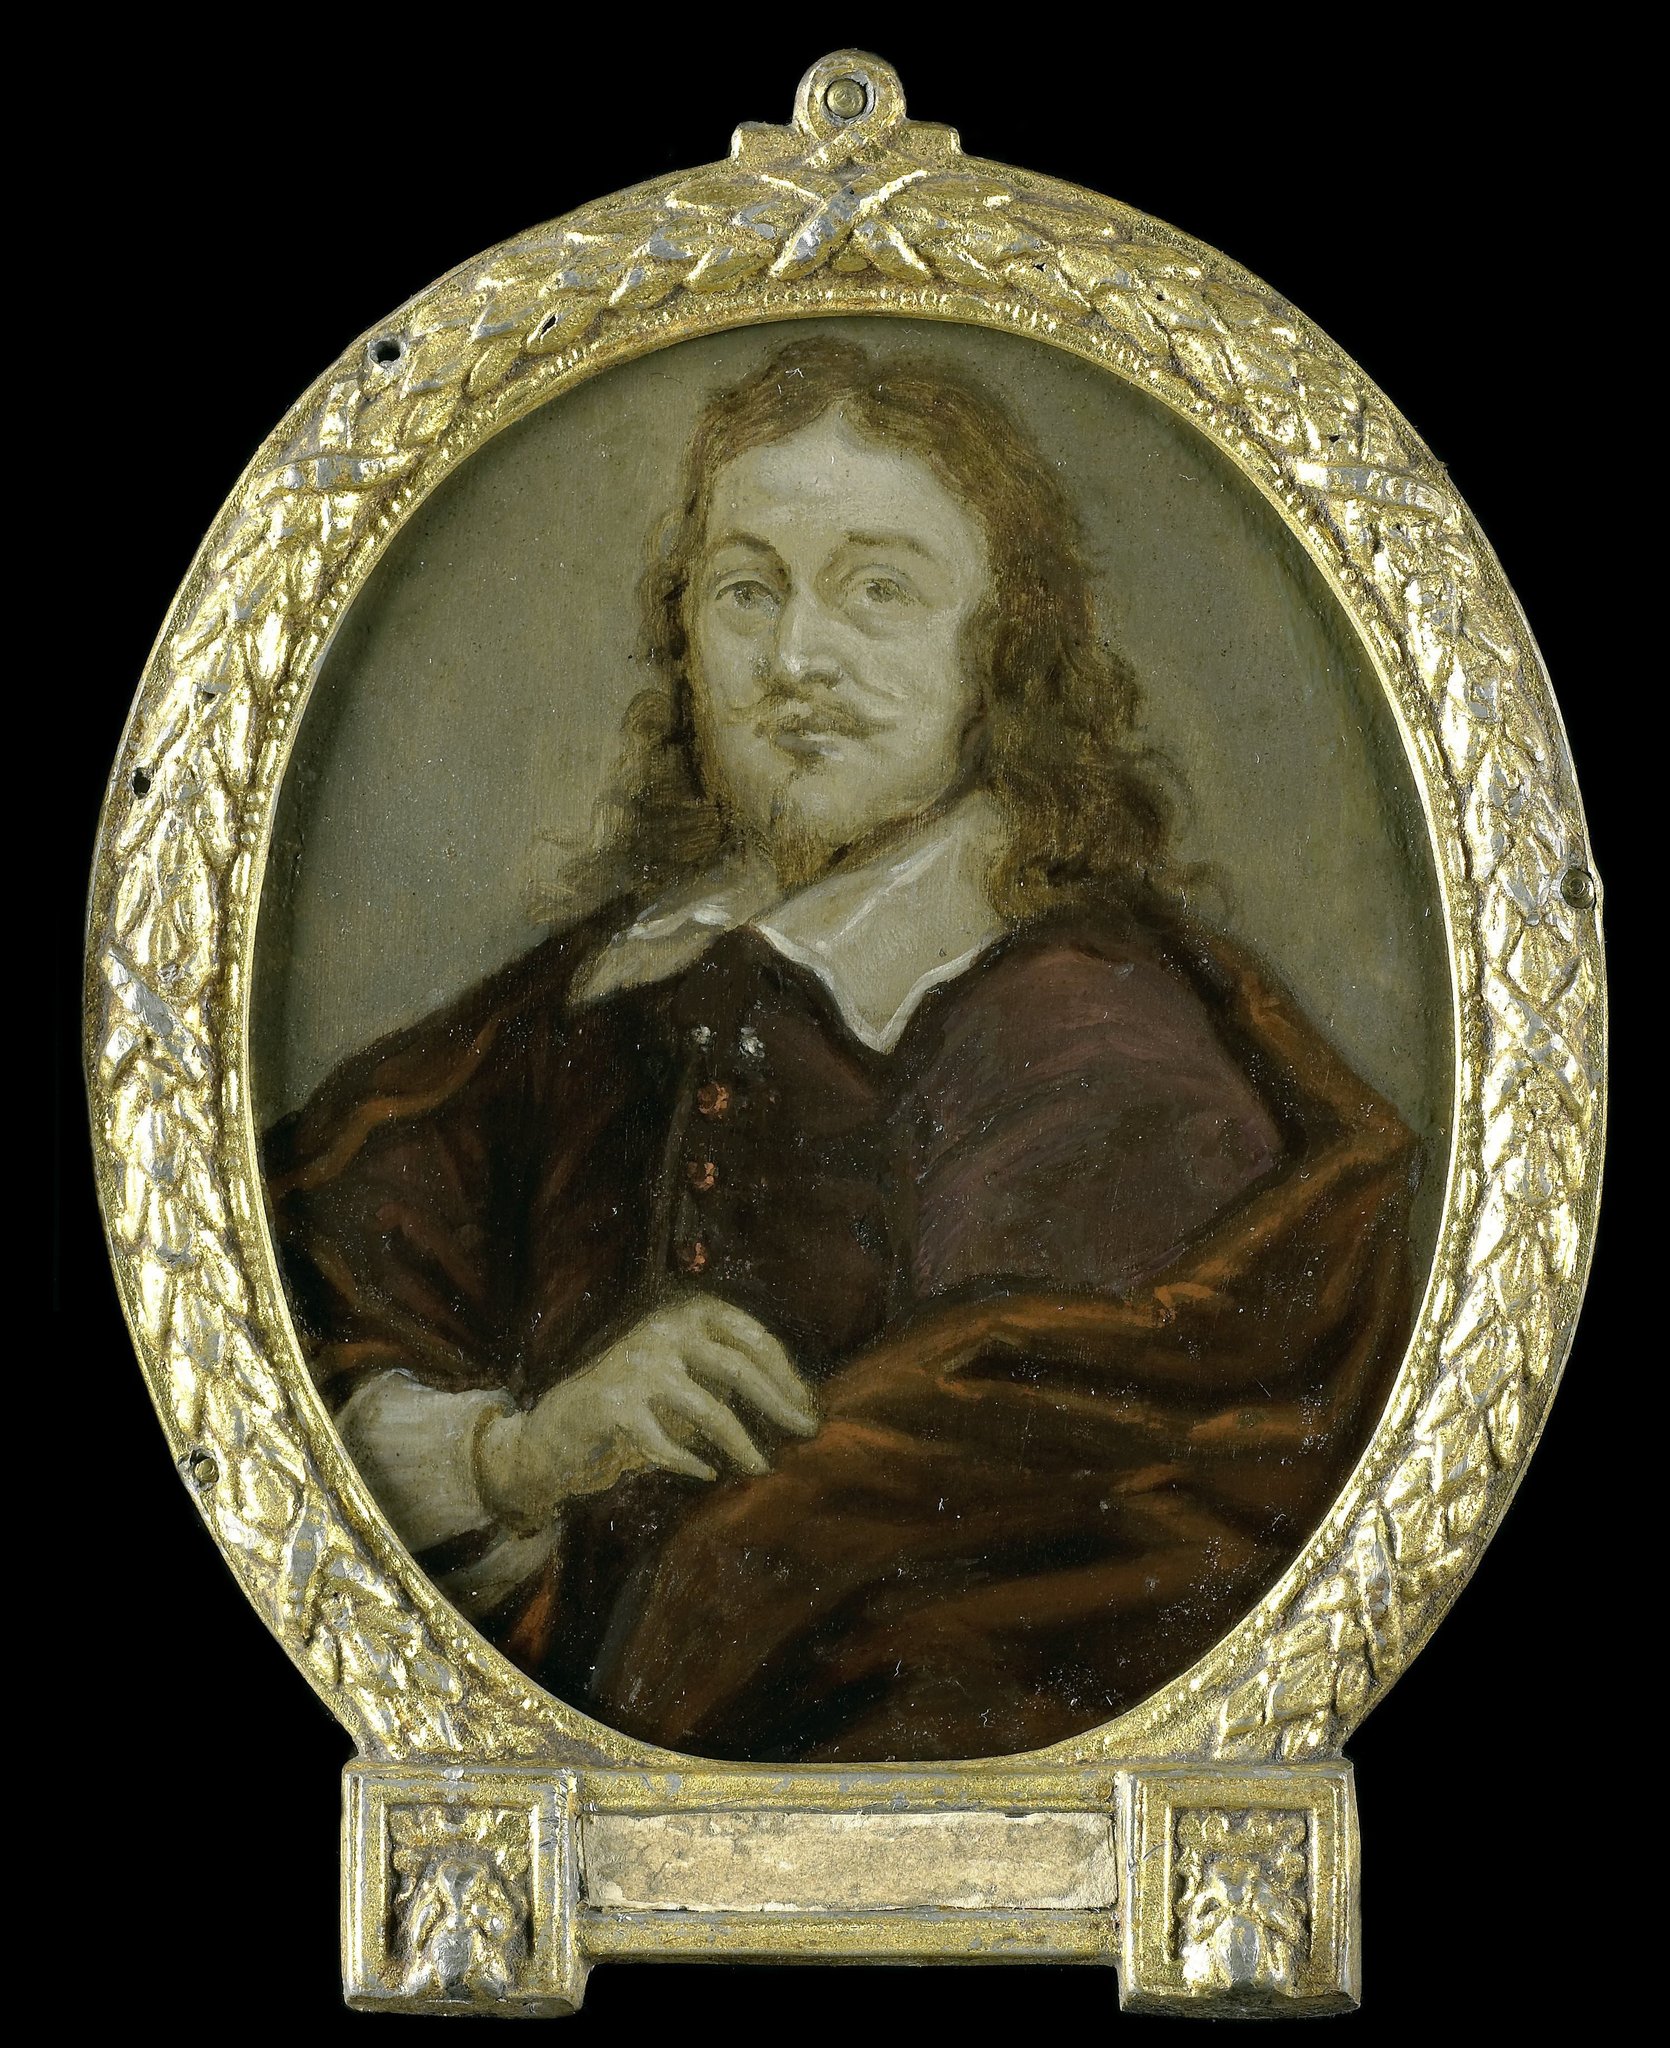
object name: painting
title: Portrait of Bonaventura Peeters I, Painter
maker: arnoud van halen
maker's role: draughtsman, painter, print maker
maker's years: 1673-1732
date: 1700-1732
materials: oil, metal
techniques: grisaille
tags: antwerp, bonaventura peeters (i), portrait of a writer, portrait, self-portrait of painter, writer, poet, author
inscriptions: inscription: ‘B Peters 1614’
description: Portret van Bonaventura Peeters I (1614-52). Schilder. Buste in ovaal, naar links. Onderdeel van een verzameling portretten van Nederlandse dichters.